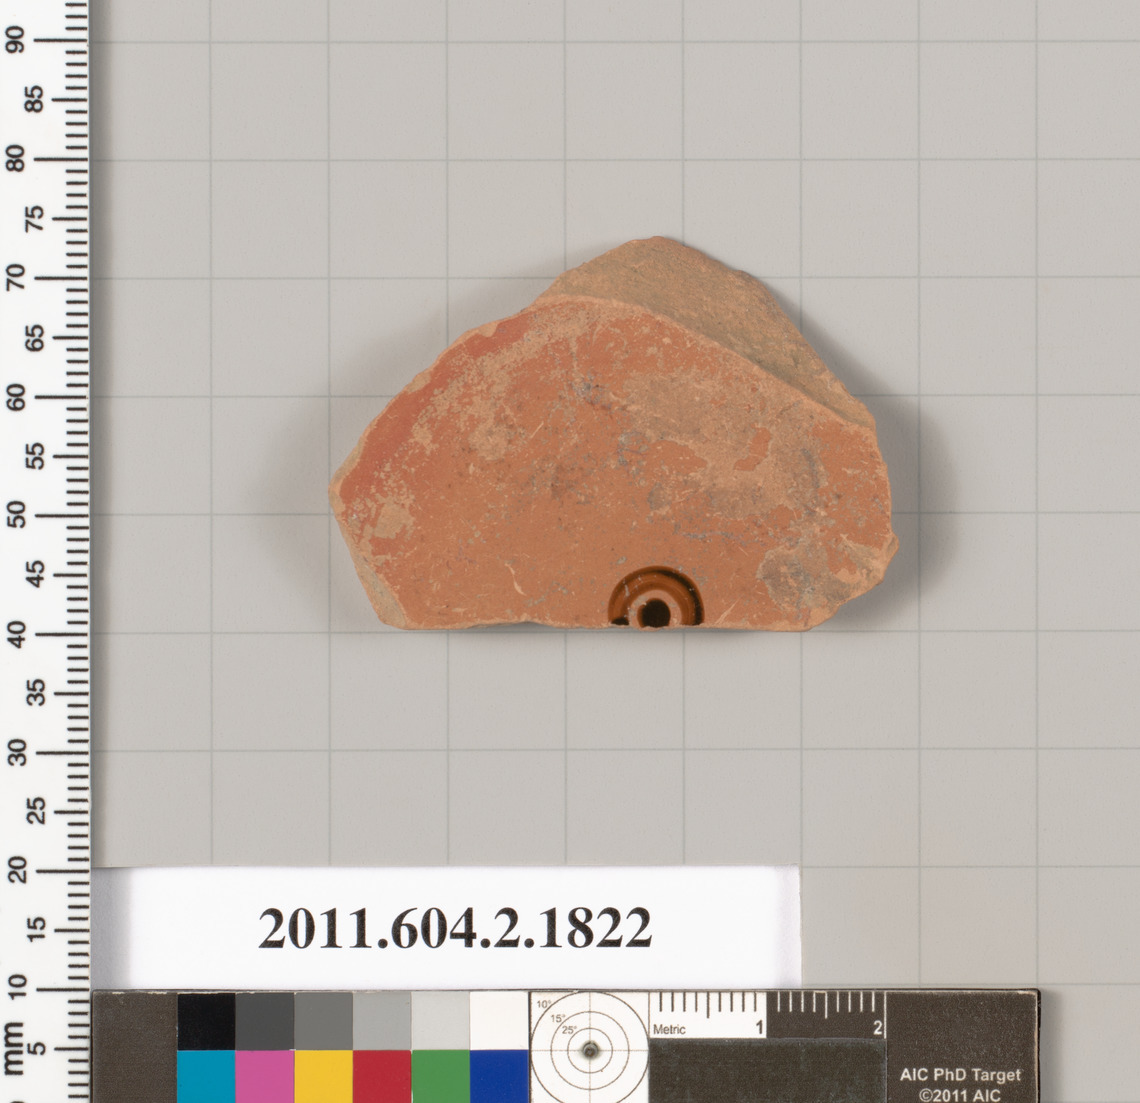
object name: skyphos fragment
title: Terracotta fragment of a skyphos (deep drinking cup)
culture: greek, attic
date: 450-401 BCE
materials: terracotta